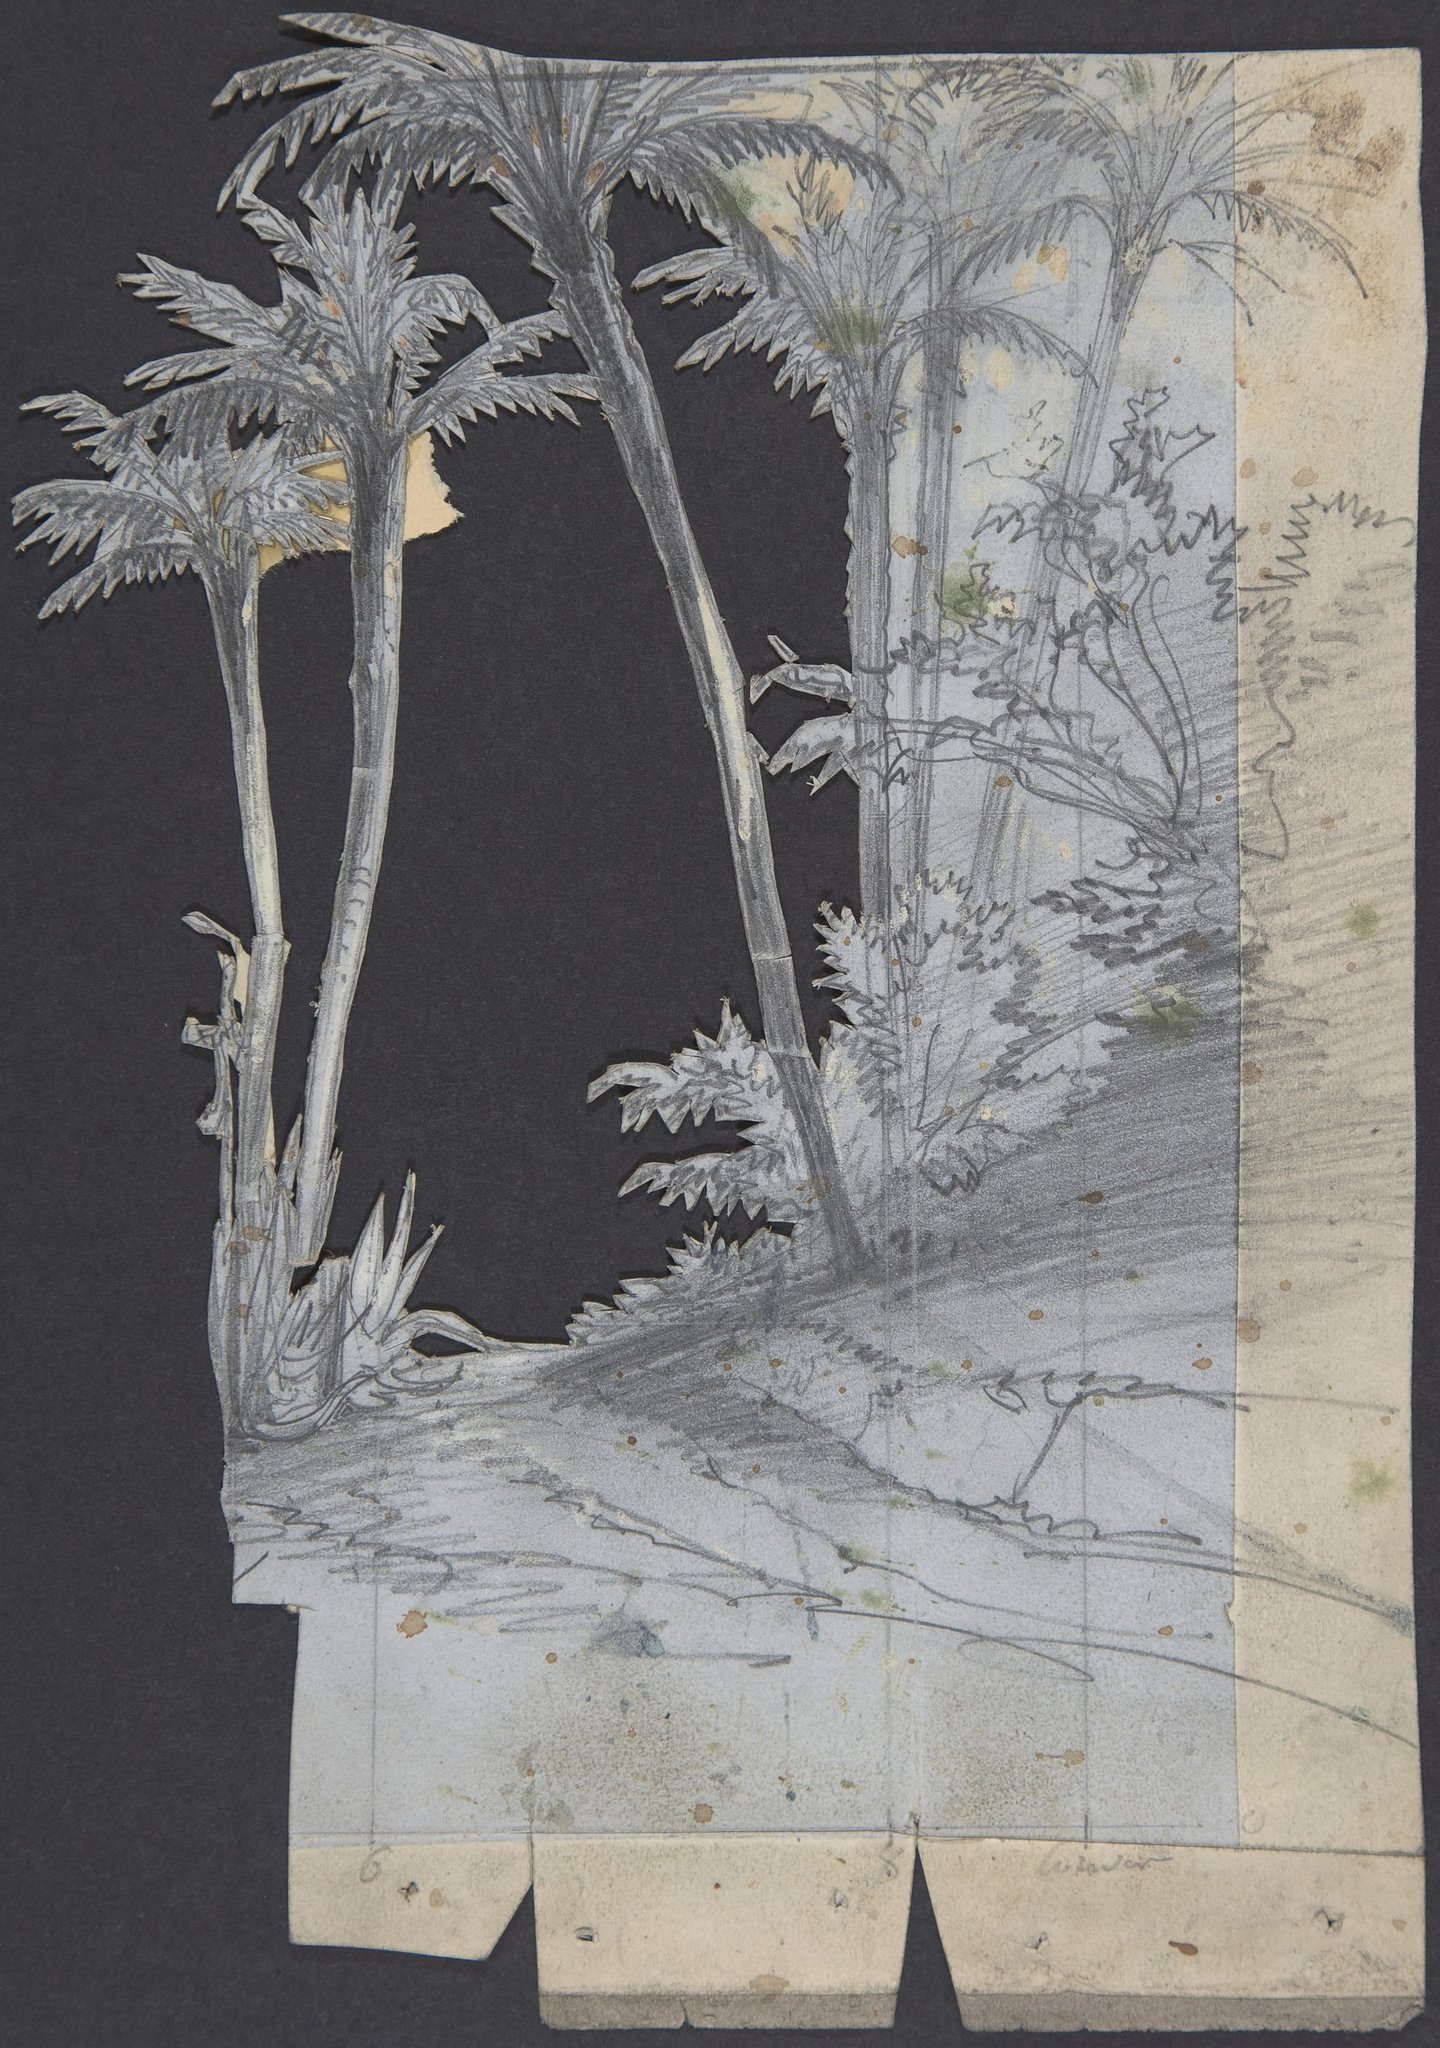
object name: drawing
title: Design for a Stage Set at the Opéra, Paris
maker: eugène cicéri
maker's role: artist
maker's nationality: french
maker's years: 1813-1890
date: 1830-1890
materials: graphite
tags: trees,stage design